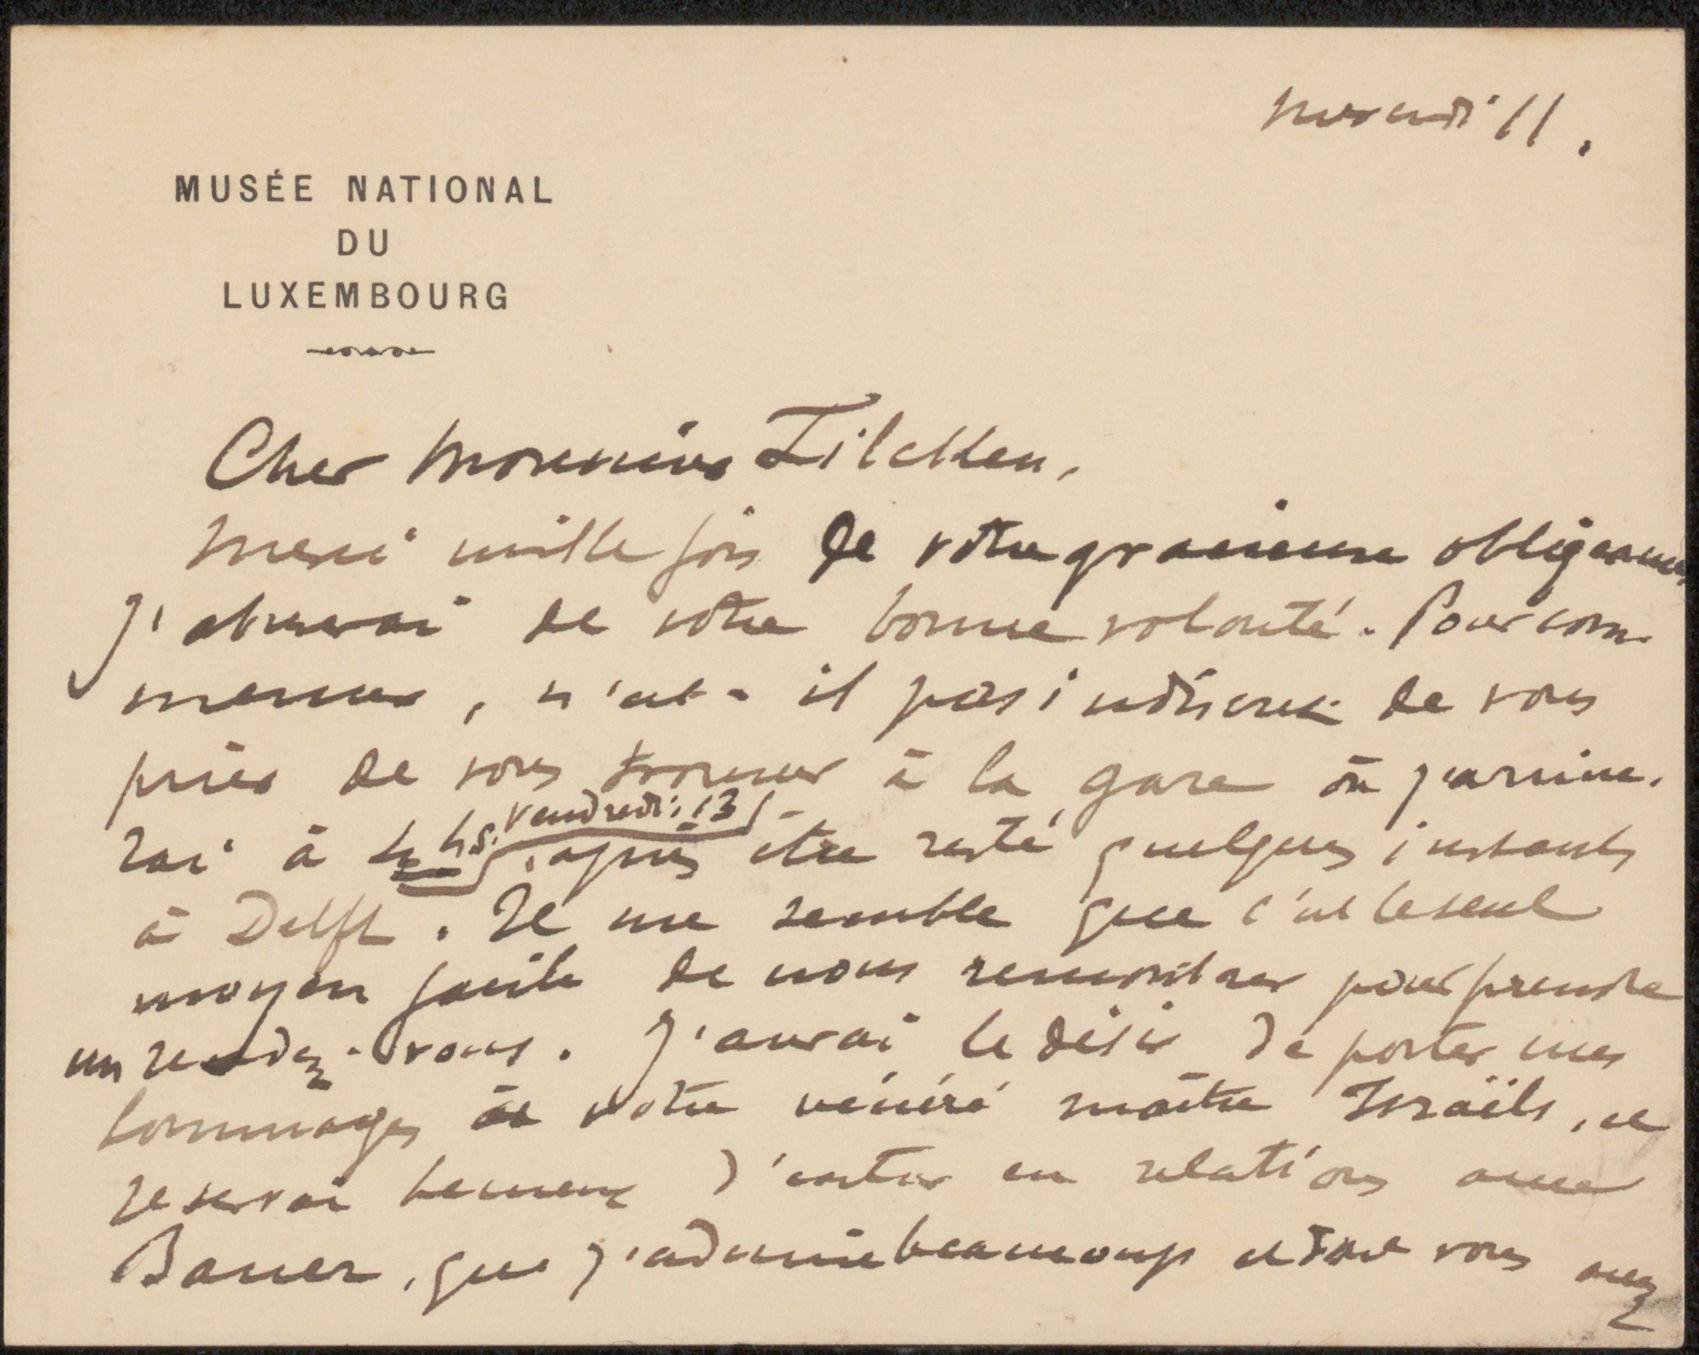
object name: letter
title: Brief aan Philip Zilcken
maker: léonce bénédite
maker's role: conservator, museumdirecteur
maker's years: 1856-1925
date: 1901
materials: cardboard, ink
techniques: pen, printing, writing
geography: rotterdam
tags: george hendrik breitner, willem maris, amsterdam, marius bauer, louis van soest, the hague, painter, print maker, draughtsman, jan toorop, philip zilcken, painting (including book-illumination, miniature-painting), delft, rotterdam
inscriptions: collector's mark: ‘RPK’